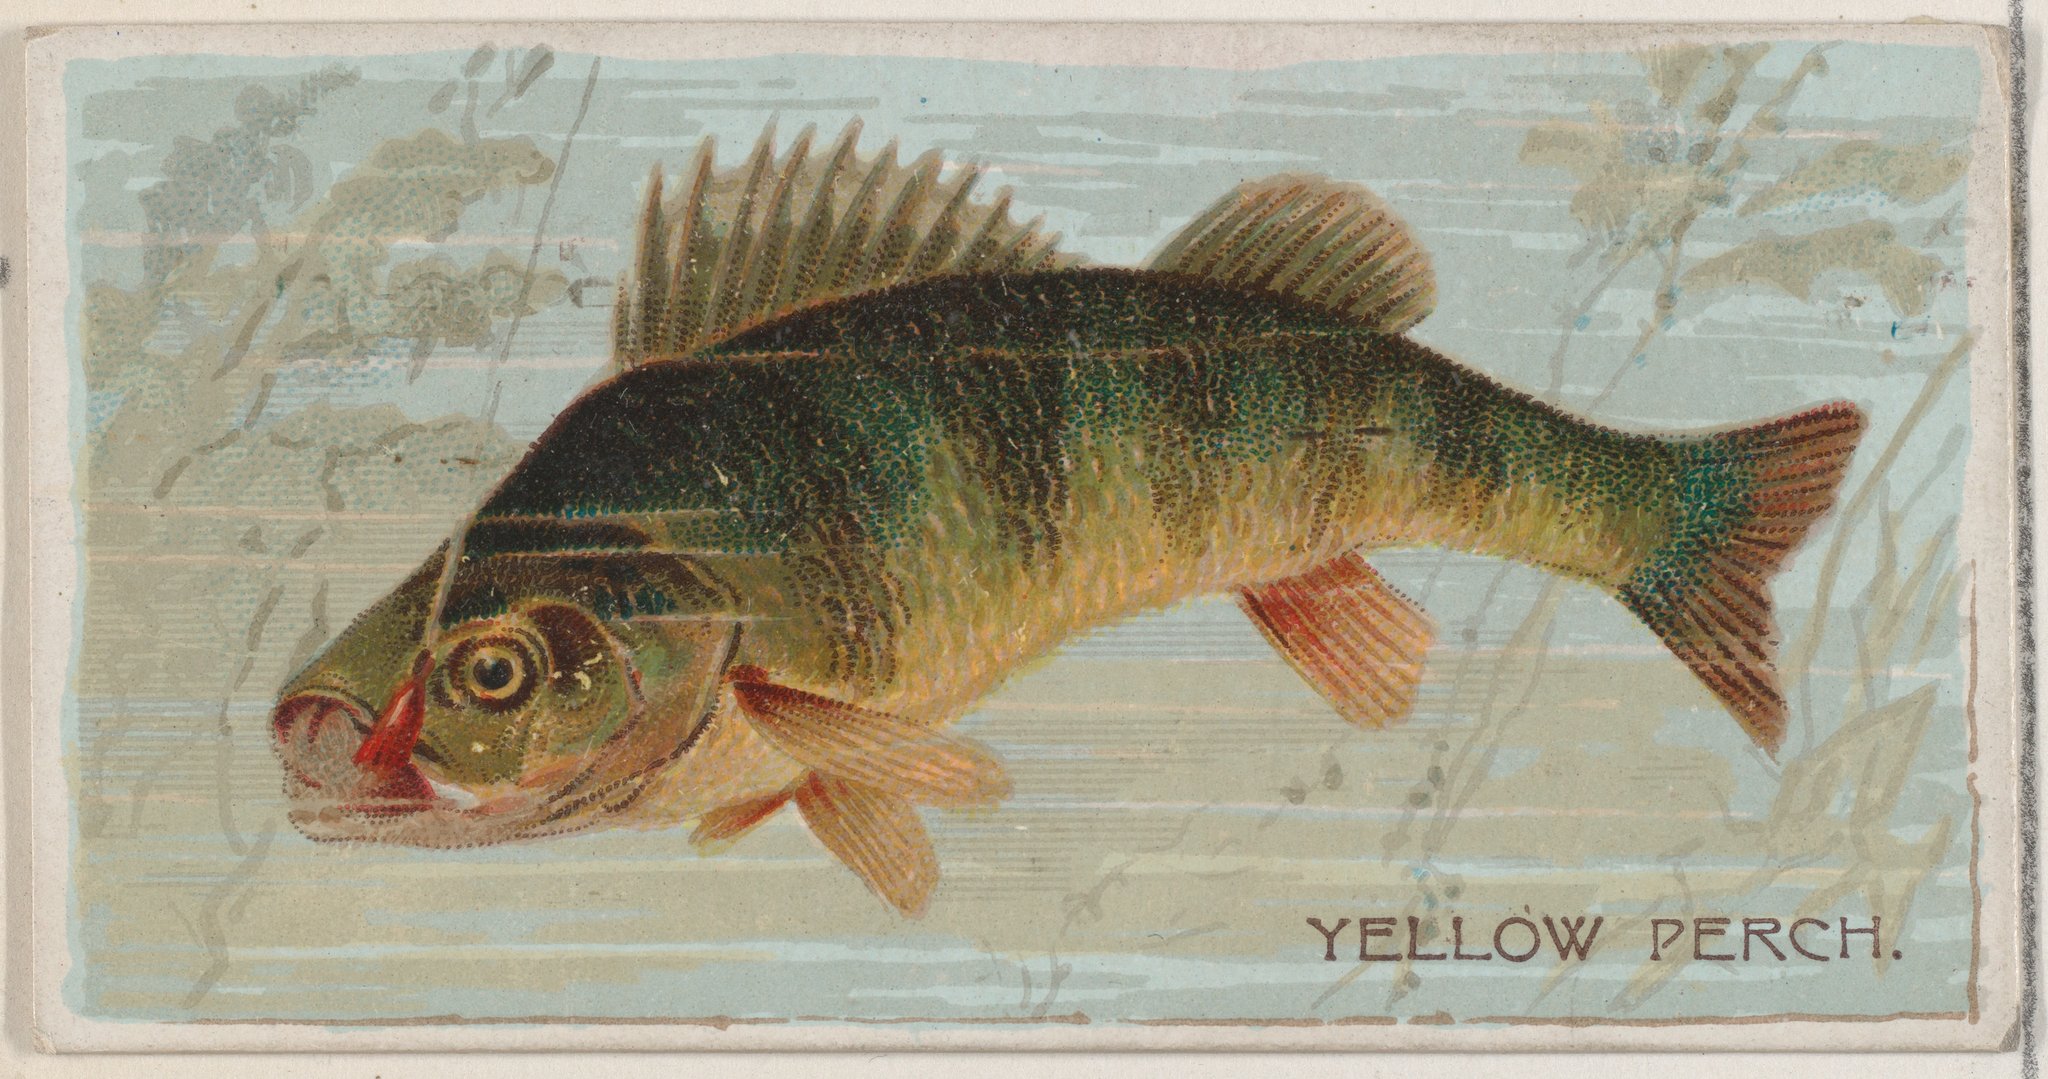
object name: print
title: Yellow Perch, from the series Fishers and Fish (N74) for Duke brand cigarettes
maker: knapp & company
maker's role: lithographer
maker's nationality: american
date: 1888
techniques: color lithograph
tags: fish